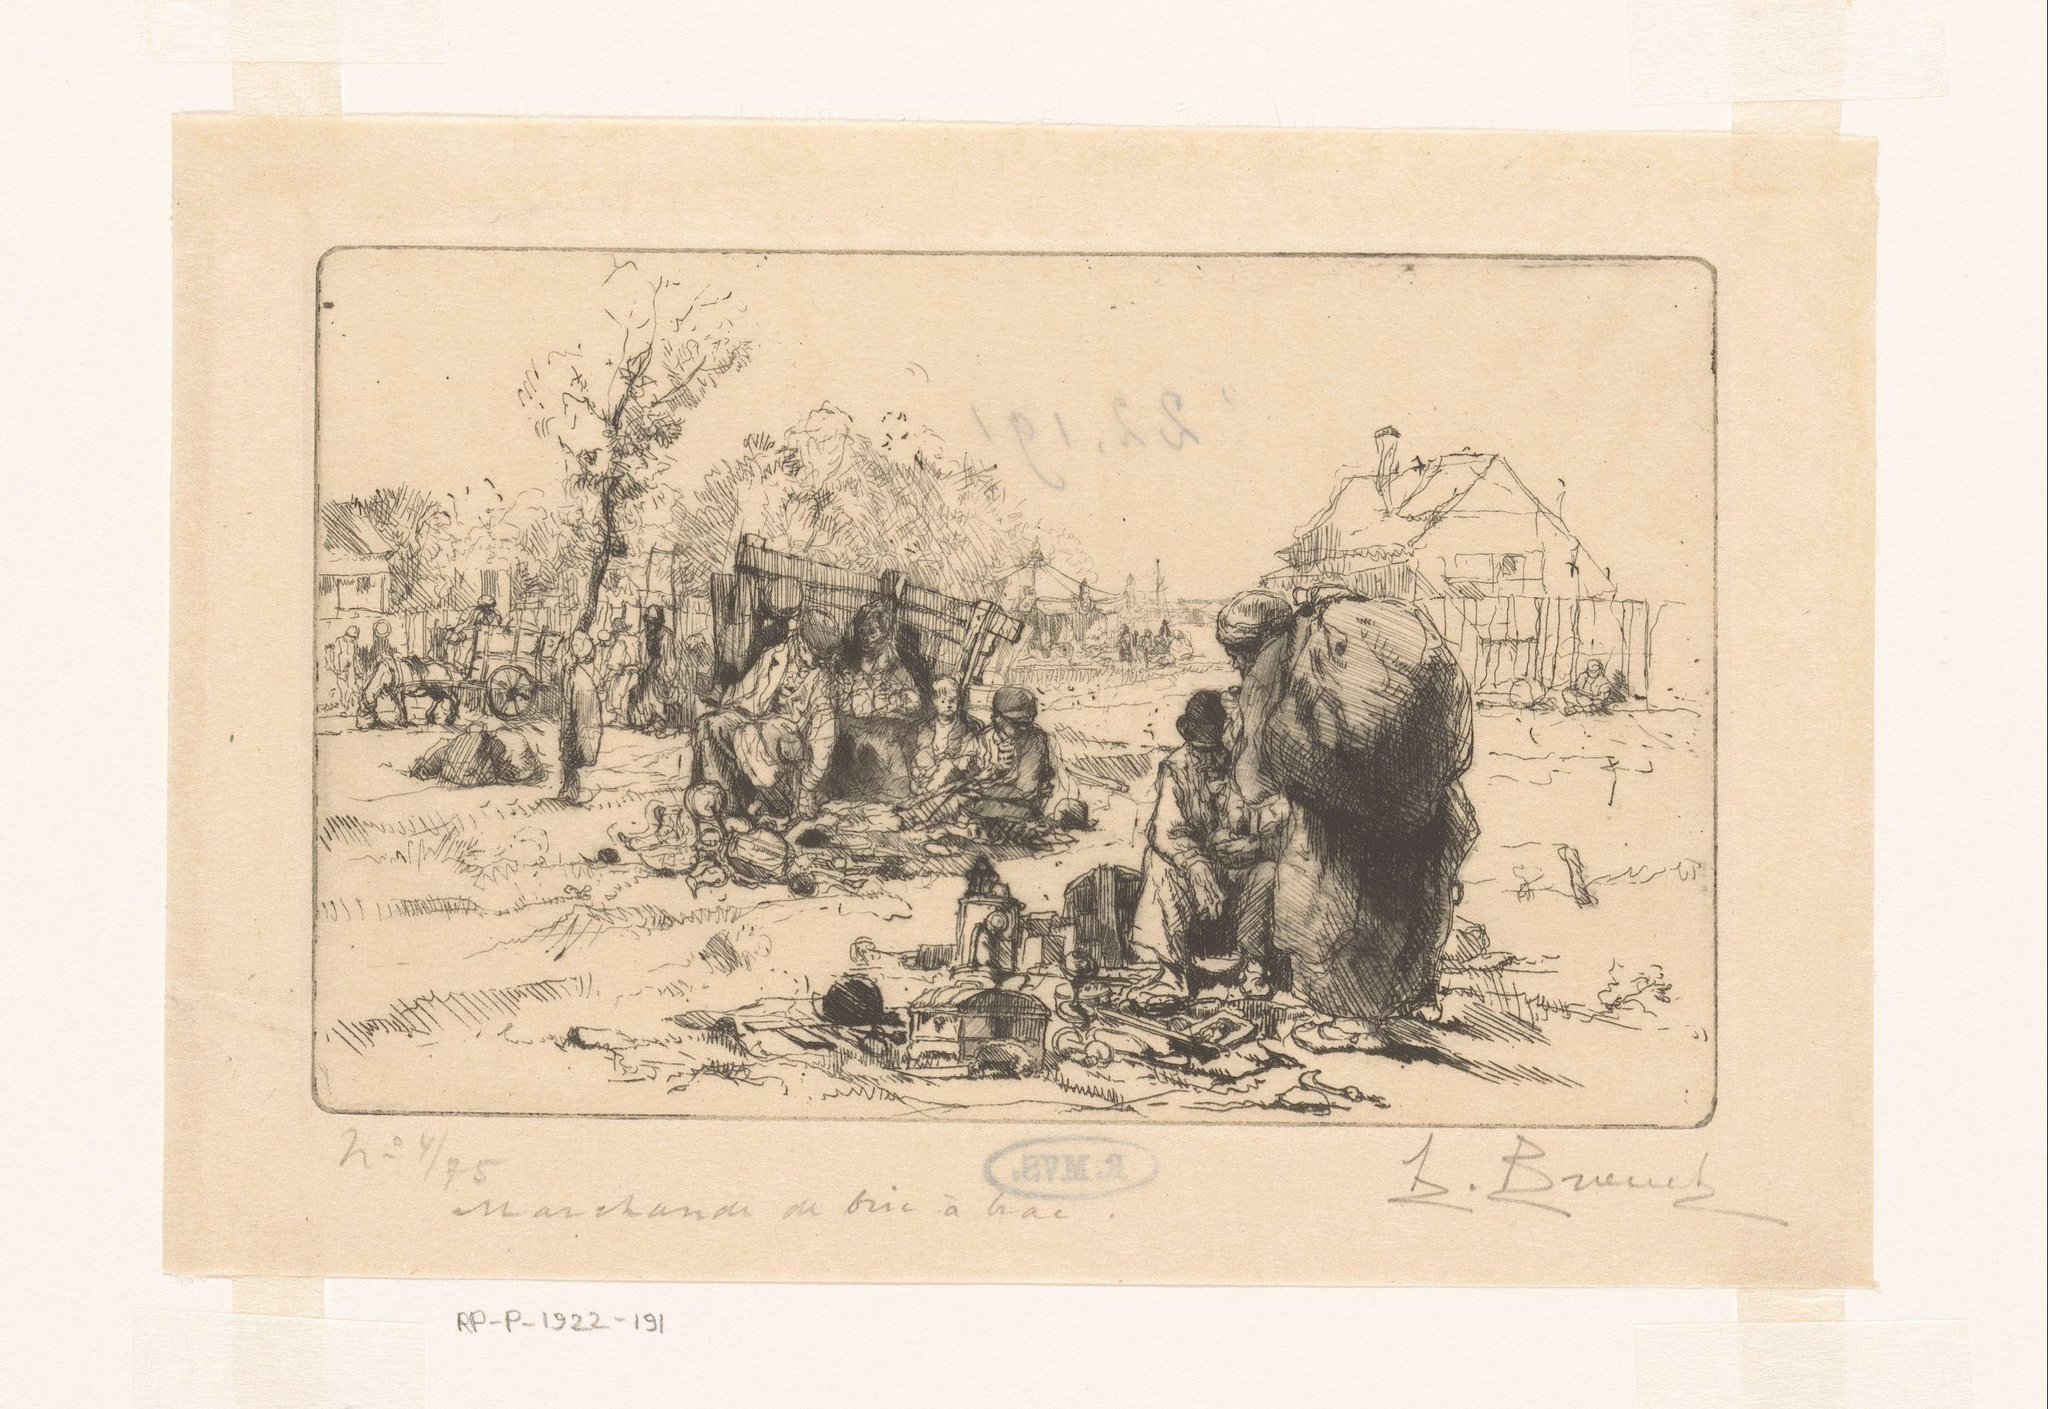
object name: print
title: Vlooienmarkt in een landschap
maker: auguste brouet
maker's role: painter, print maker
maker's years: 1872-1941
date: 1882-1922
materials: paper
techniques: drypoint, etching, intaglio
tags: merchant, salesman - bb - women engaged in trade and commerce, market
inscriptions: collector's mark: Lugt 2228